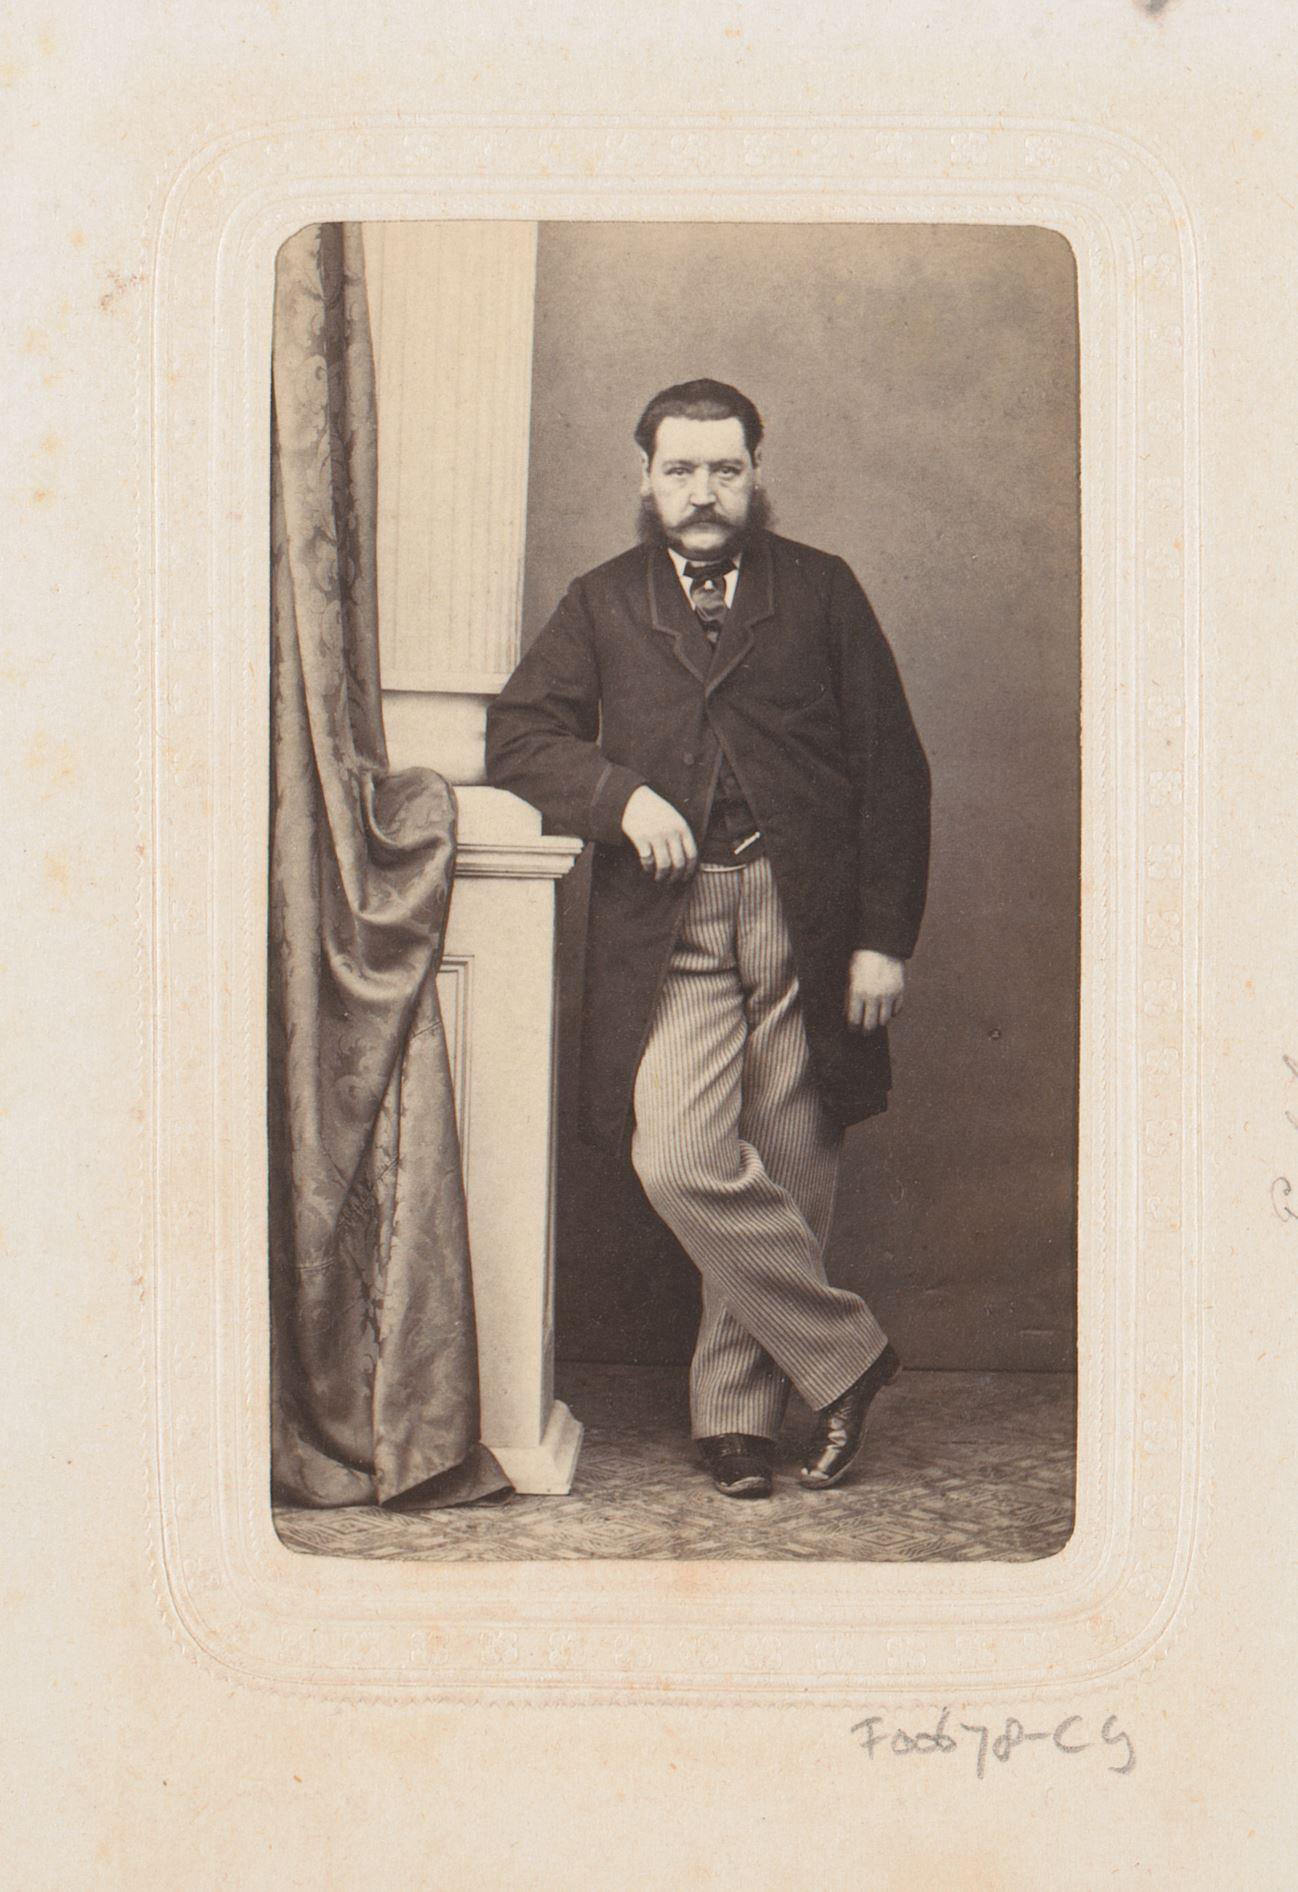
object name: album leaf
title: Portret van een staande man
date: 1860-1880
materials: cardboard, photographic support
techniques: albumen print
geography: salzburg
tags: historical persons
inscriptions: inscription: ‘Baldi & Würthle/ photographisches anstalt/ Salzburg/ Riedenburg, Villa Baldi, No. 17’, annotation: ‘Salzburg’